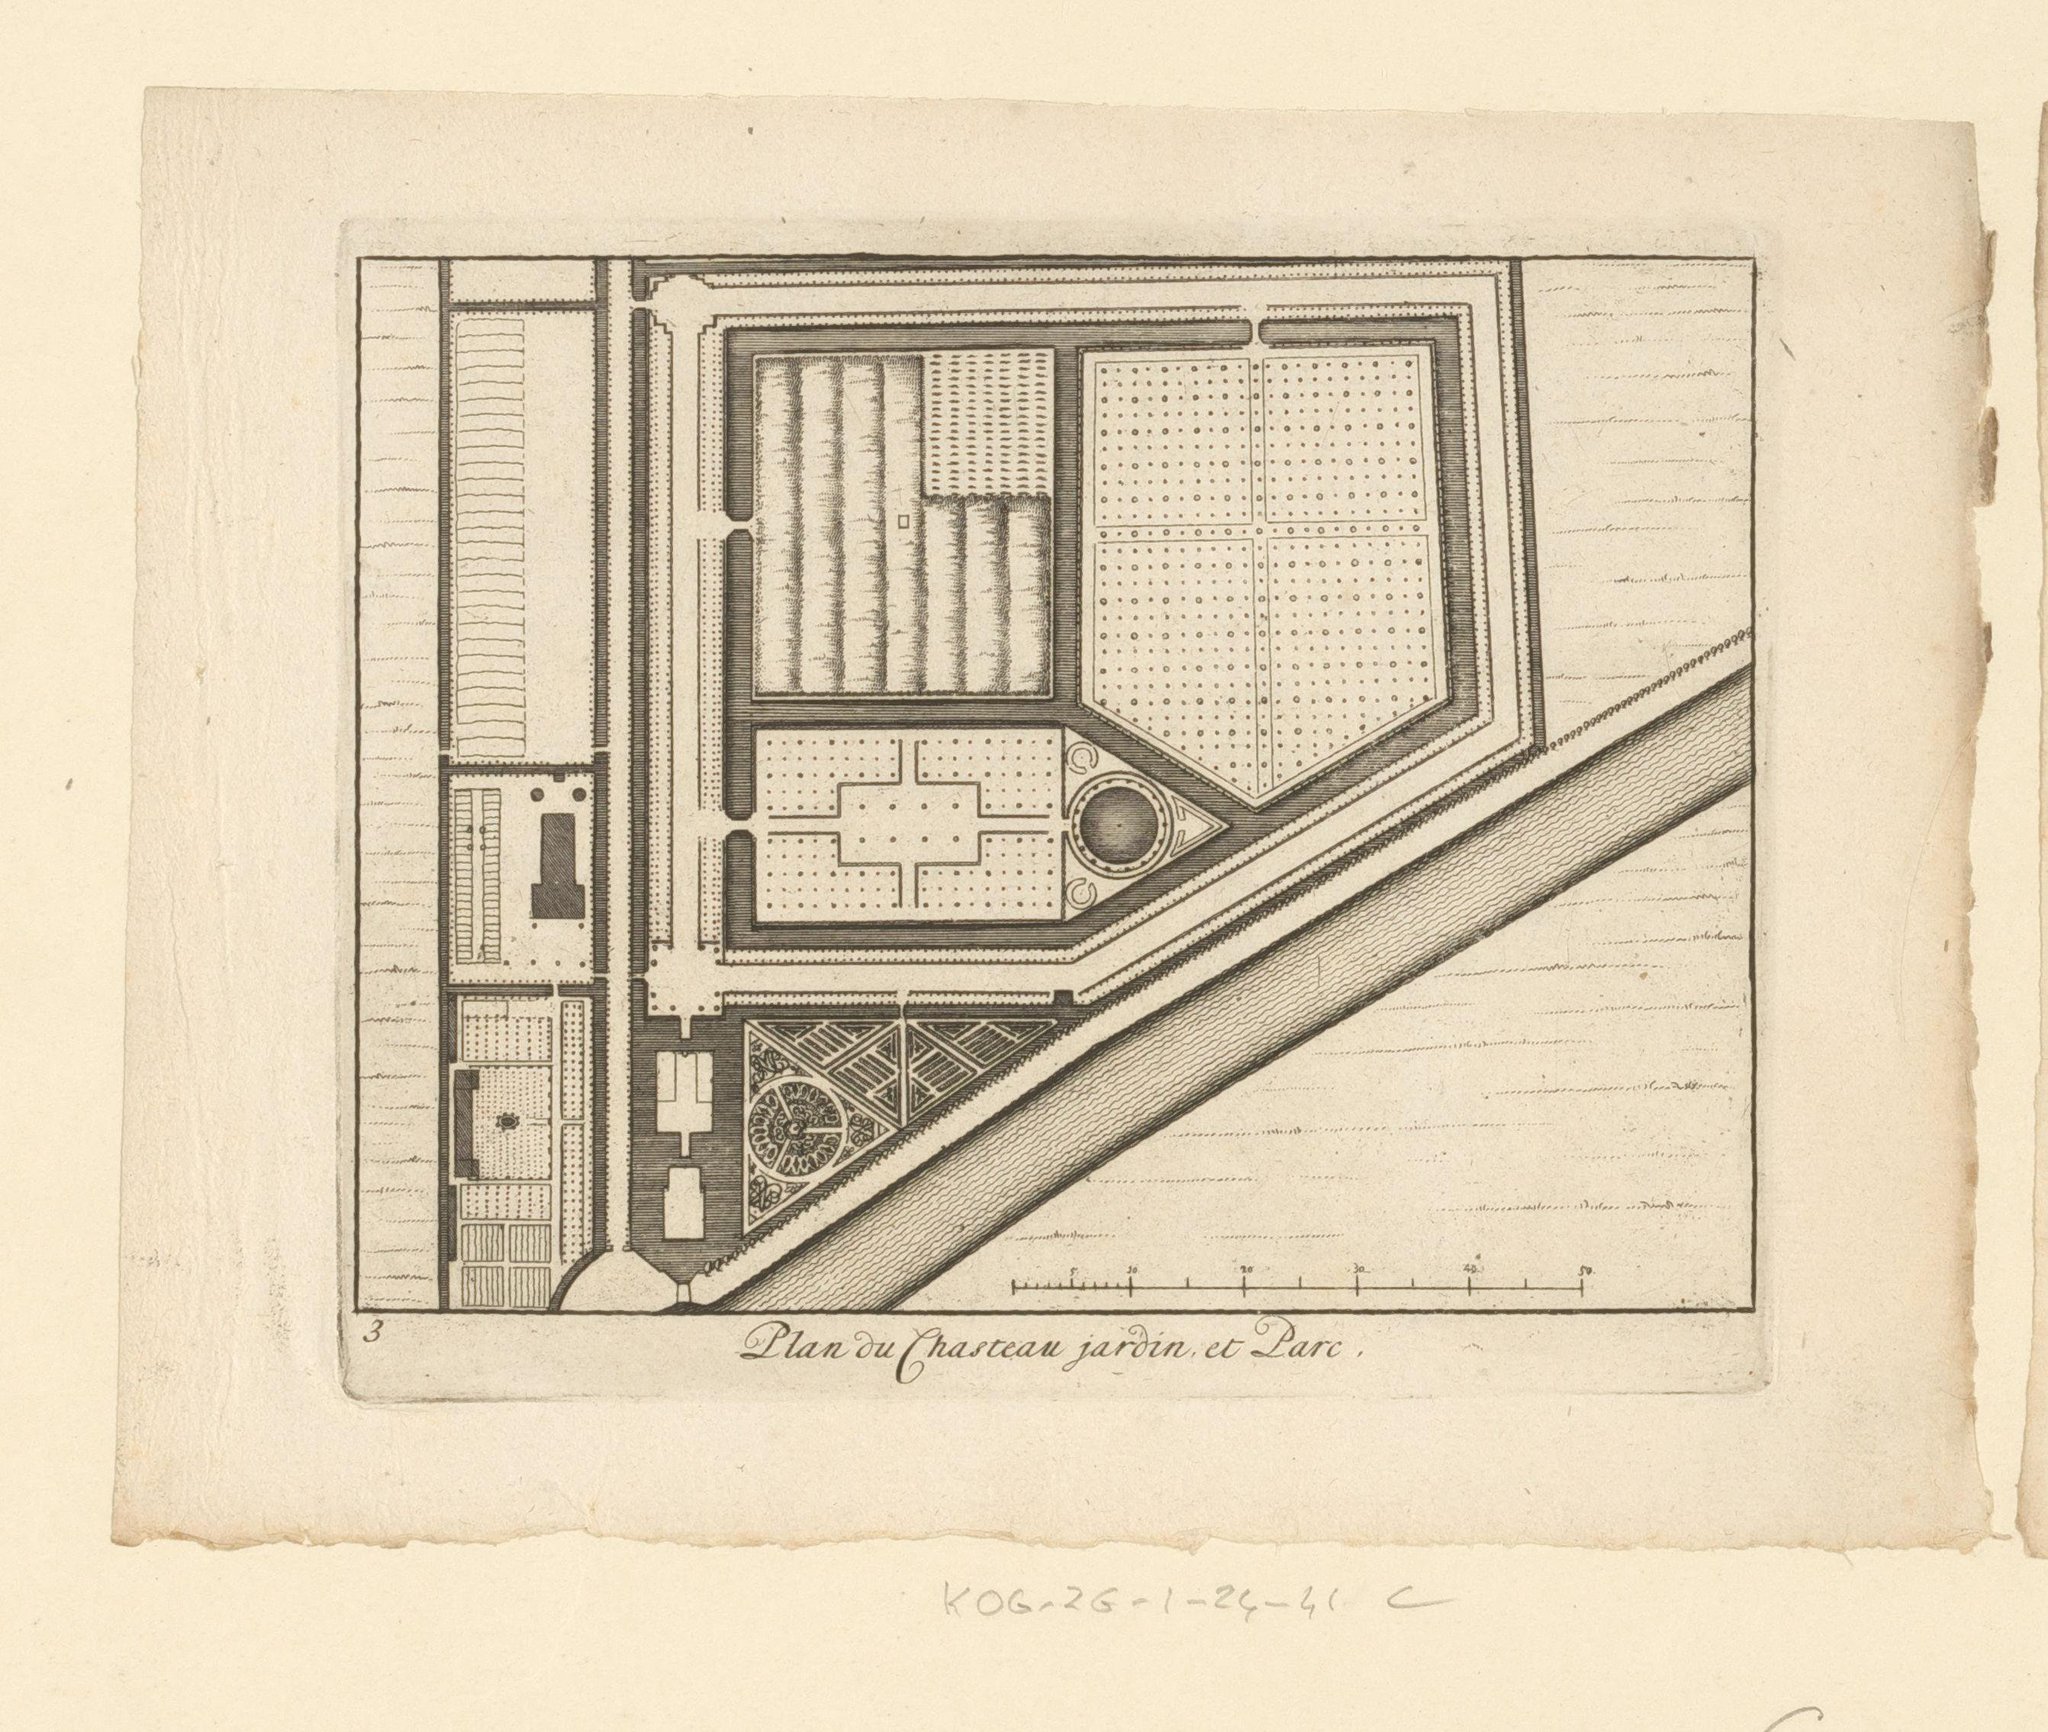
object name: book illustration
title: Plattegrond van landgoed Gunterstein, Breukelen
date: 1721-1774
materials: paper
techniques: engraving, etching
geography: amsterdam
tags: magdalena poulle, lay-out of garden, plan ~ architecture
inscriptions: stamp, stamp, collector's mark: Lugt 1641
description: Plattegrond van kasteel Gunterstein en de bijbehorende tuinen te Breukelen. Linksonder genummerd: 3. Onderwerpsrubrieken binnen de Atlas Zeden en Gewoonten: Zeden en Gewoonten in Engeren Zin, De Woning. Kastelen en buitenplaatsen. Utrecht (vervolg.).